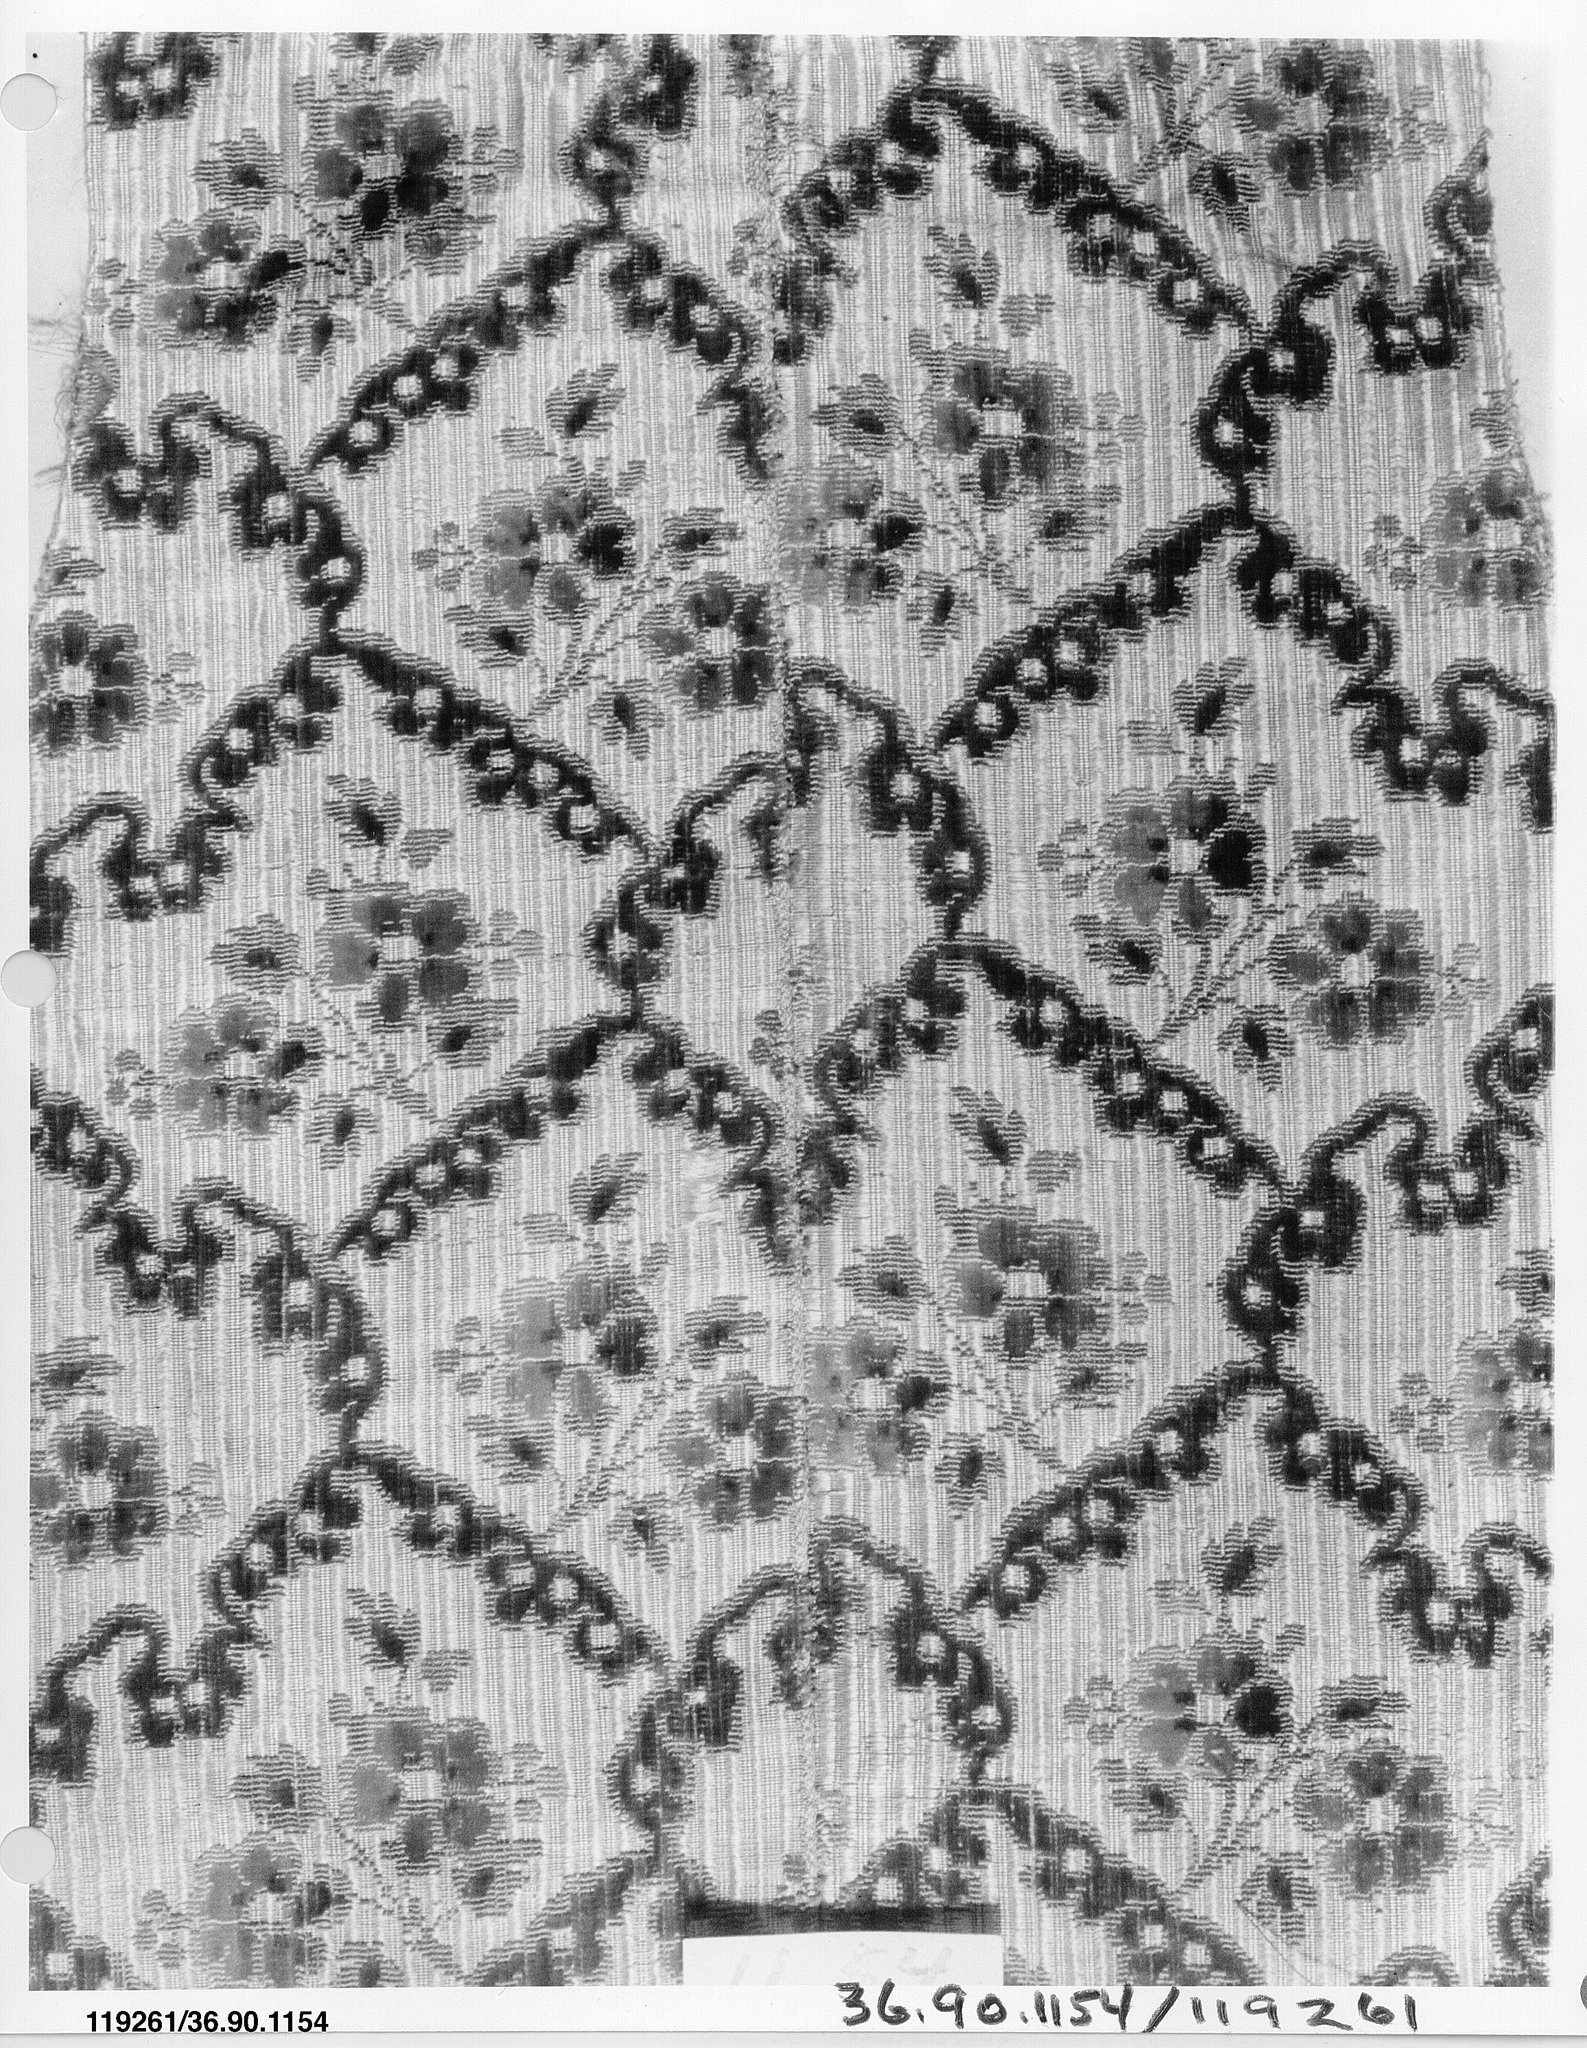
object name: piece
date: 1767-1800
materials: silk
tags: flowers,leaves